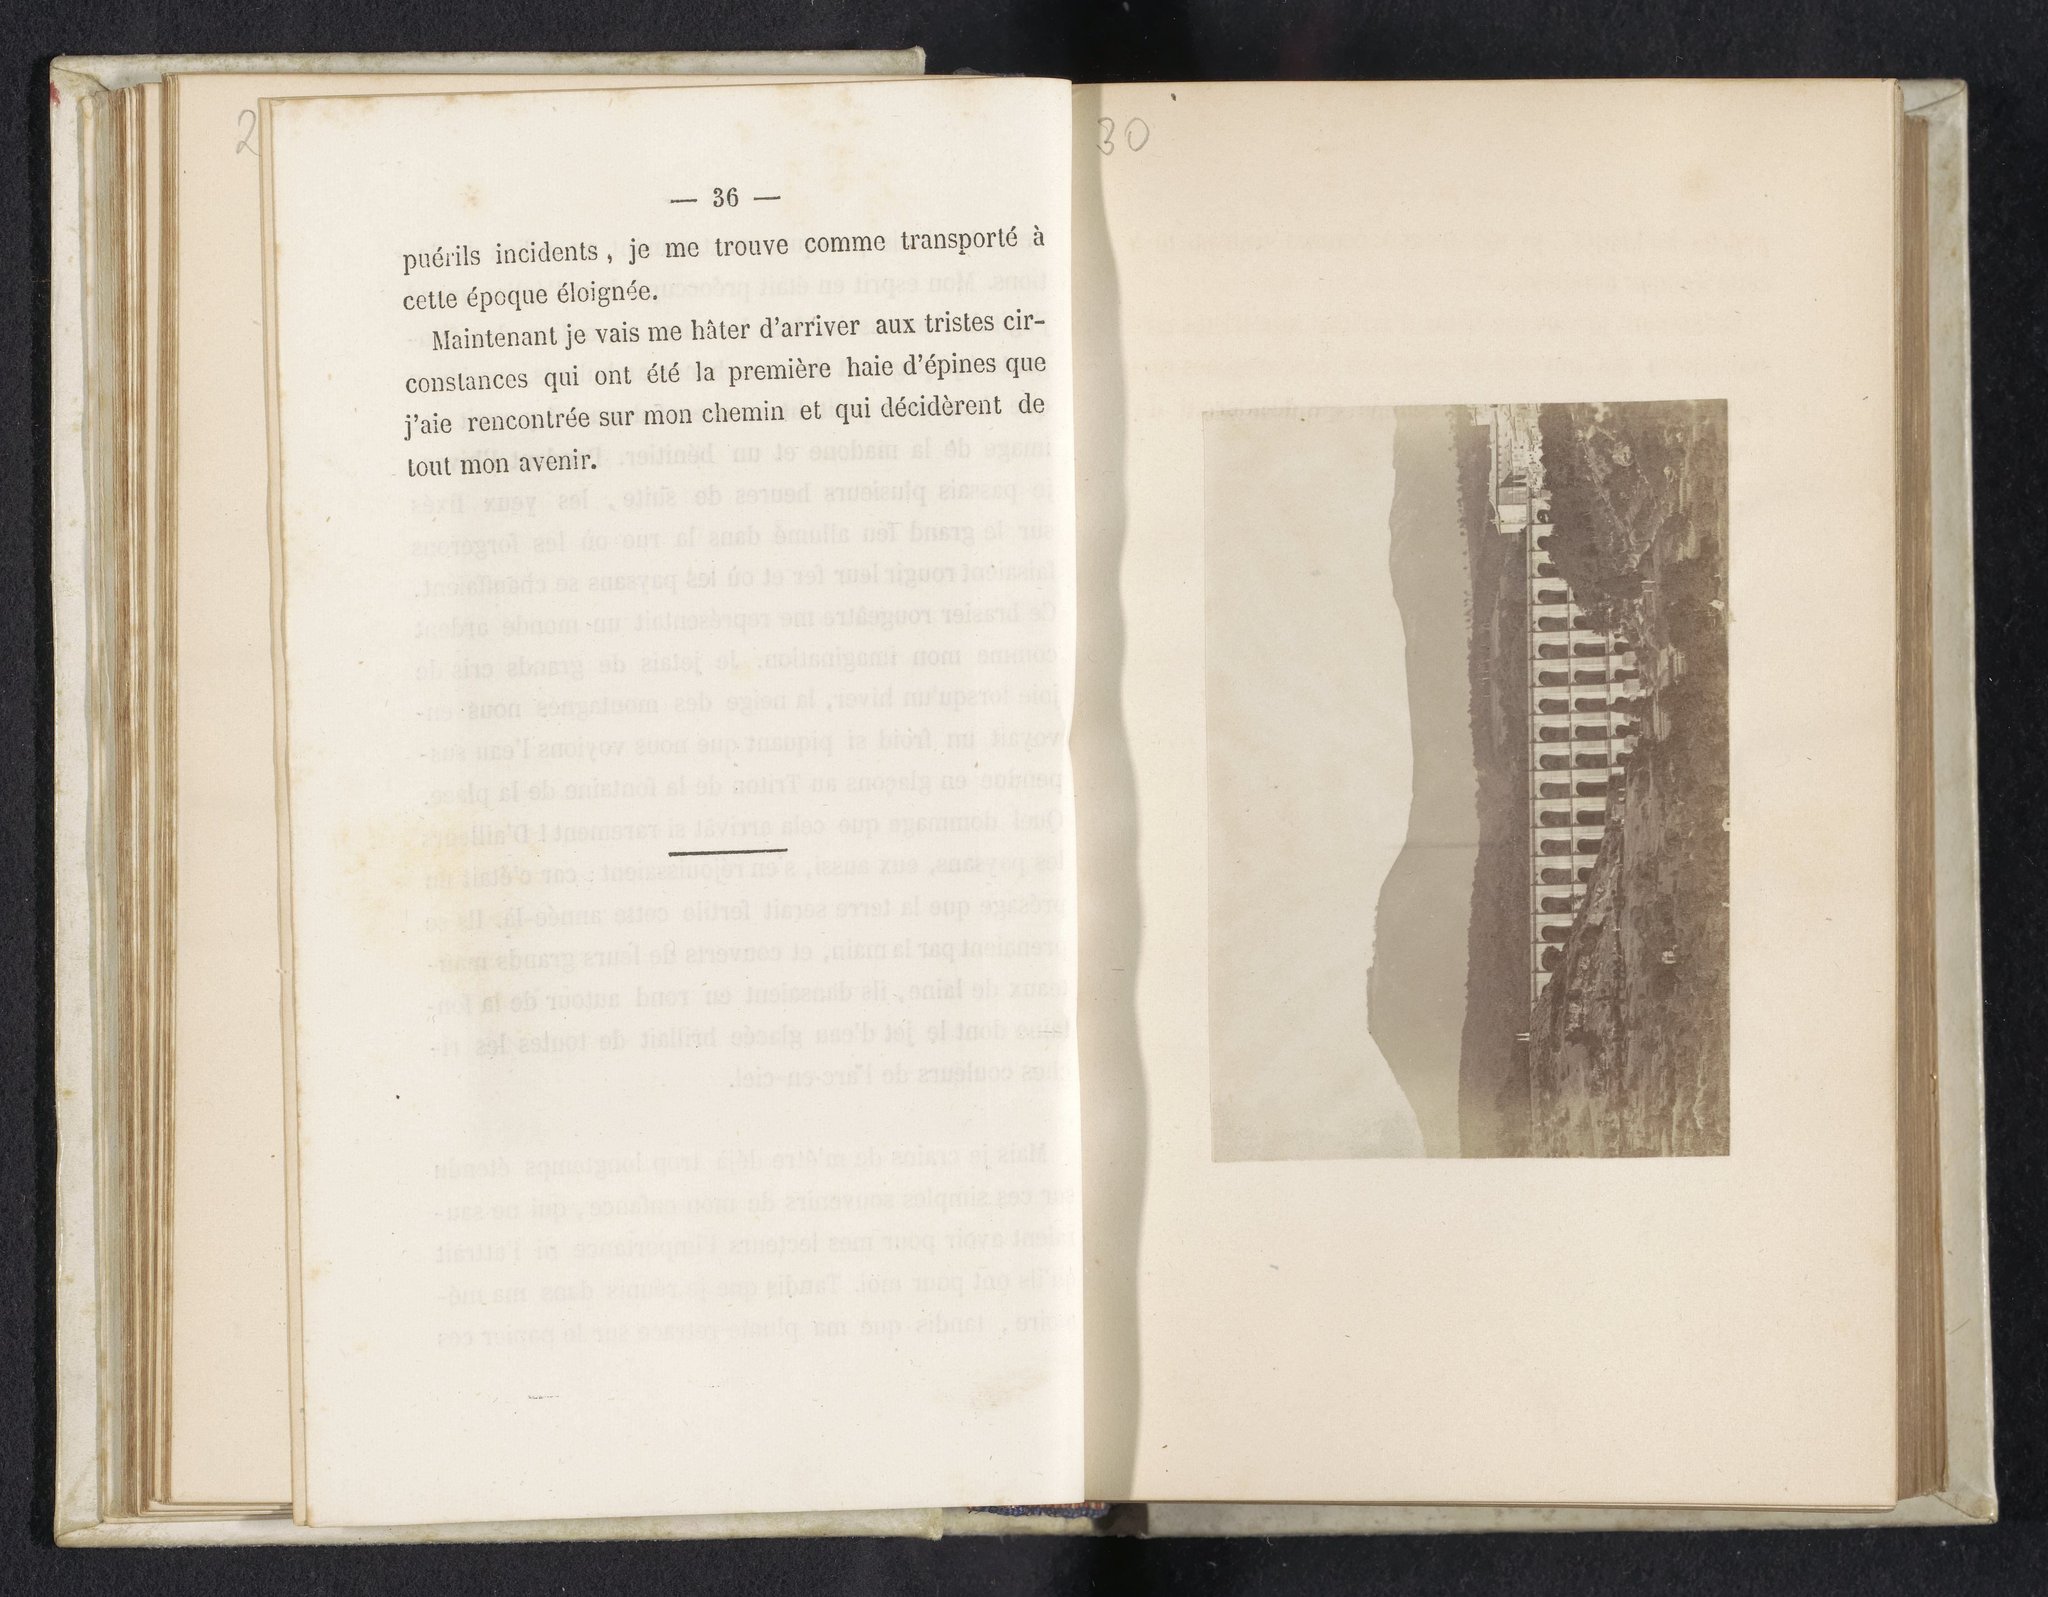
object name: photograph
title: Gezicht op een aquaduct te Ariccia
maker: Anonymous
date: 1850-1860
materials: photographic support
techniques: albumen print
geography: lazio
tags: landscape with bridge, viaduct or aqueduct